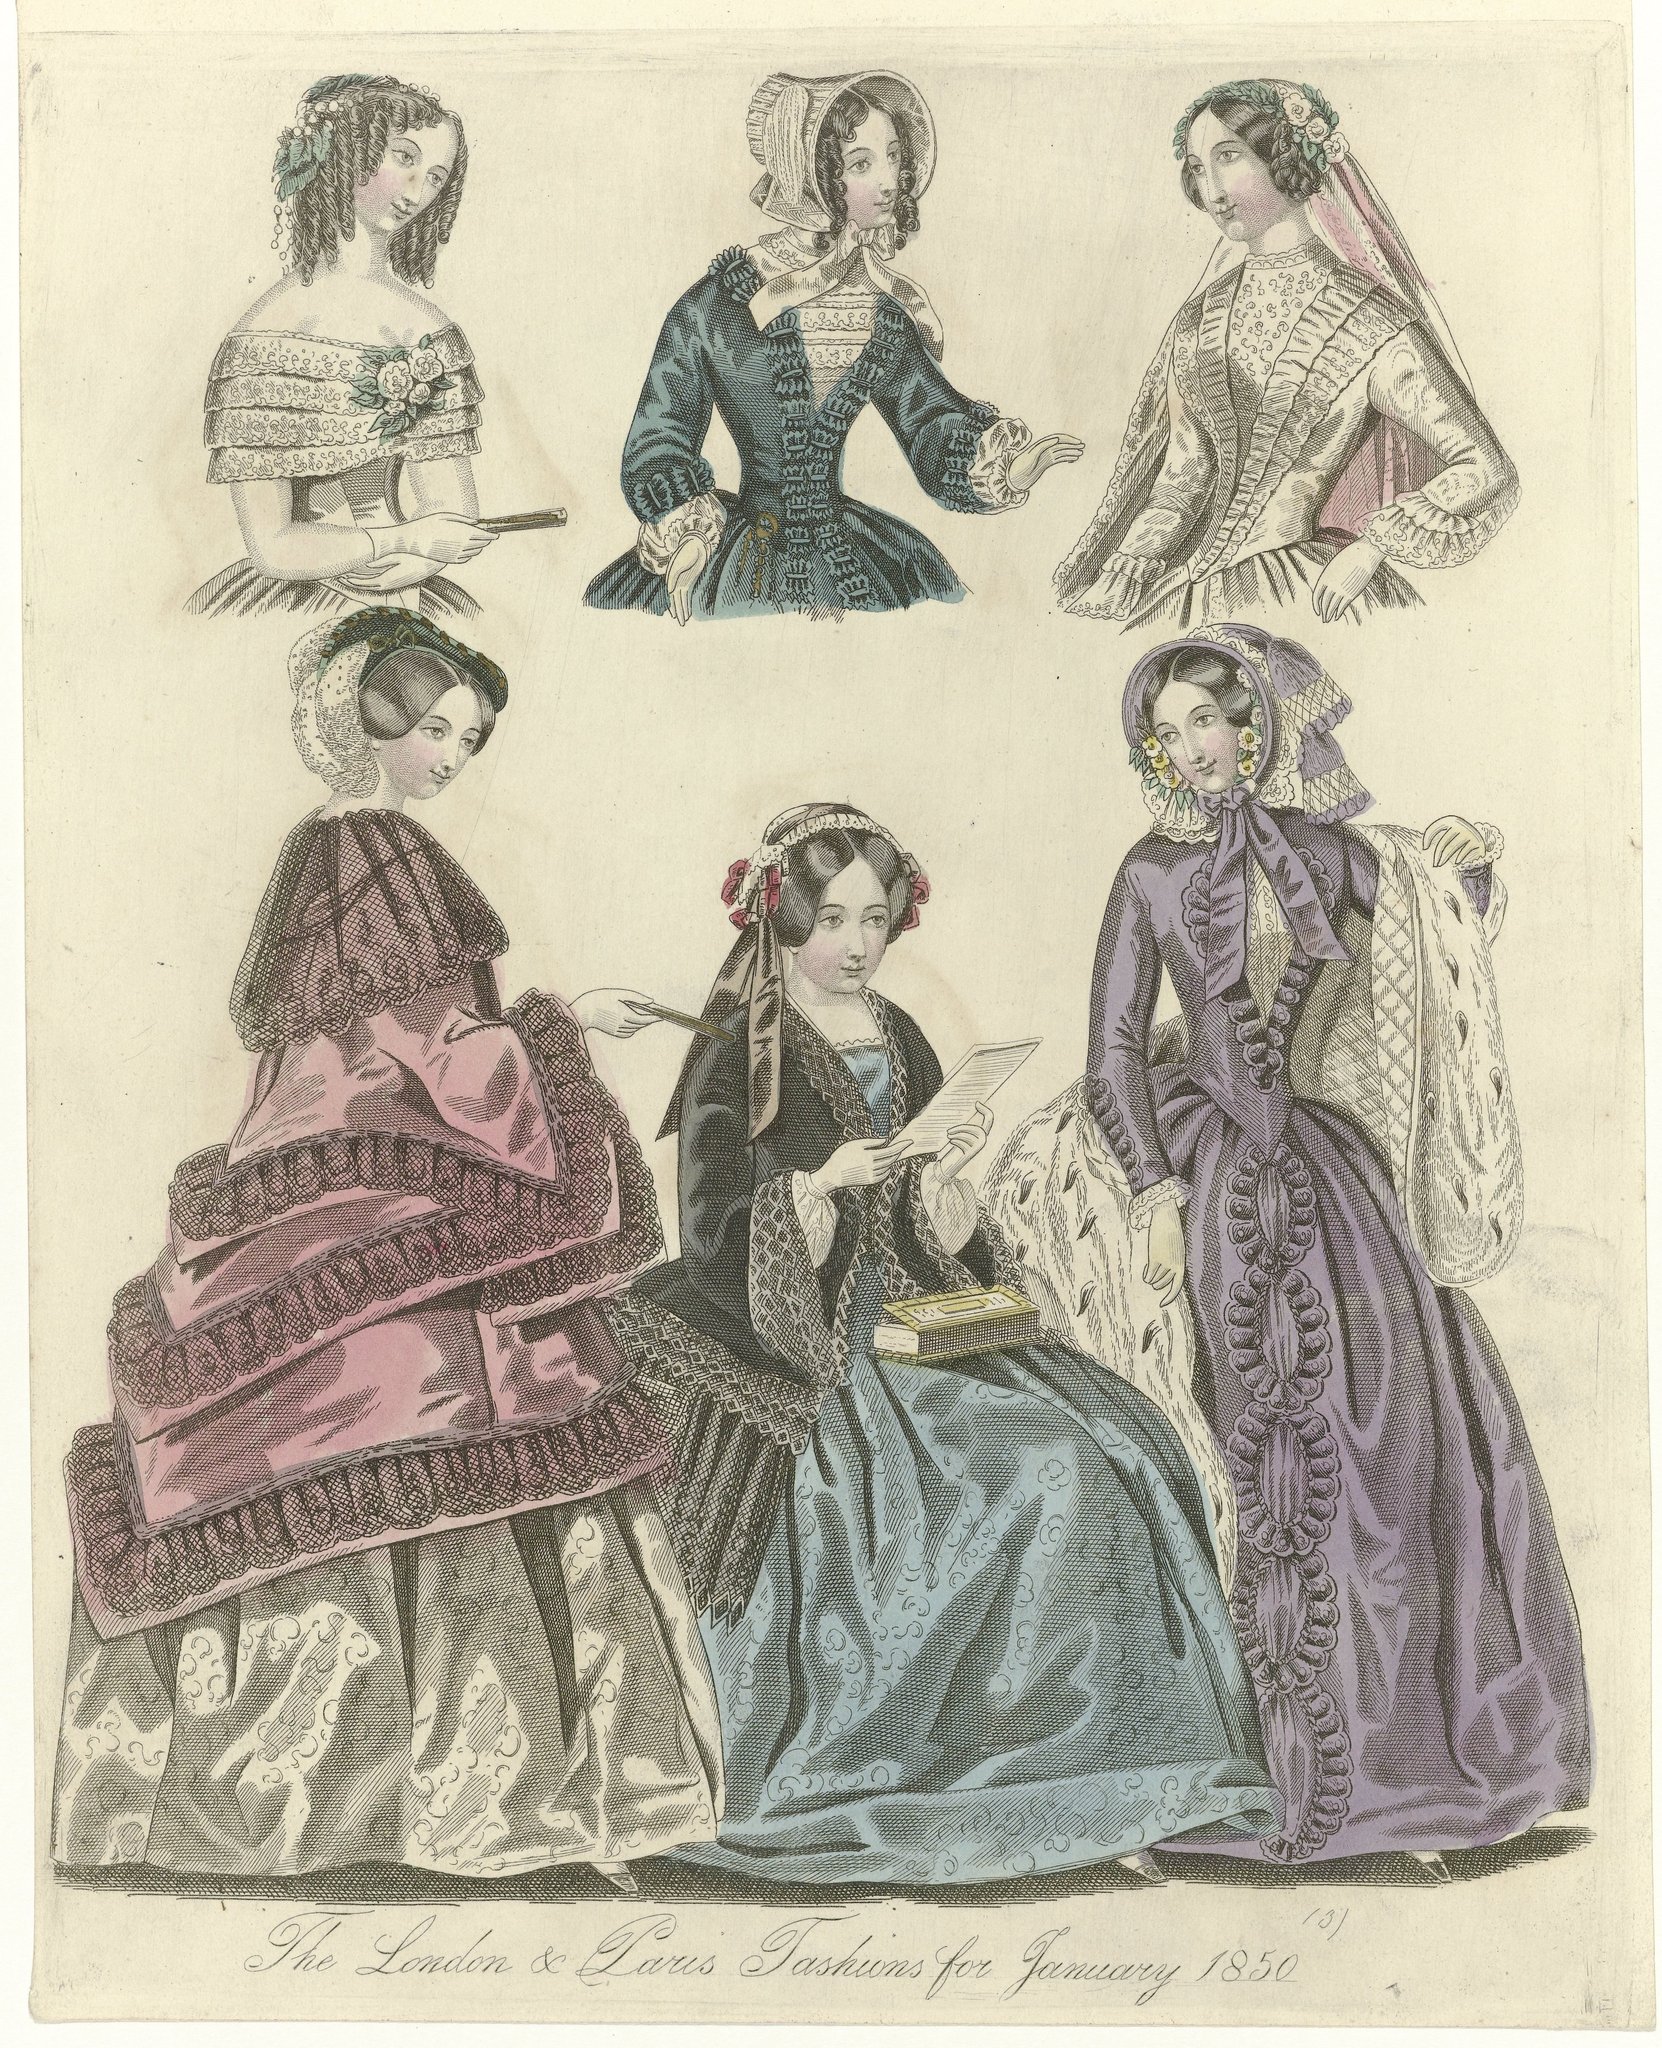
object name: fashion print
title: The World of Fashion, january 1850 : The London & Paris Fashions (...)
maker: Anonymous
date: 1850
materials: paper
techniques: etching, hand coloring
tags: dress, gown: evening dress (+ women's clothes), veil (+ women's clothes), head-gear: beret (+ women's clothes), coat (+ fur used for clothes), coat (+ women's clothes), head-gear: cap (+ women's clothes), fashion plates, head-gear: hat (+ women's clothes), letter, envelope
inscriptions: caption: ‘The London & Paris Fashions for January 1850 (3)’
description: Modes voor januari 1850 uit Londen en Parijs. Onder: twee mantels afgezet met gerimpelde stroken stof. Mantel van hermelijn, gewatteerd(?). Boven: drie vrouwen, ten halven lijve, in een avondjapon, japon met lange mouwen en trouwjapon(?). Accessoires: baret, muts, luifelhoeden, sluier, handschoenen, waaier. Prent uit het modetijdschrift The World of Fashion (1824-1891).